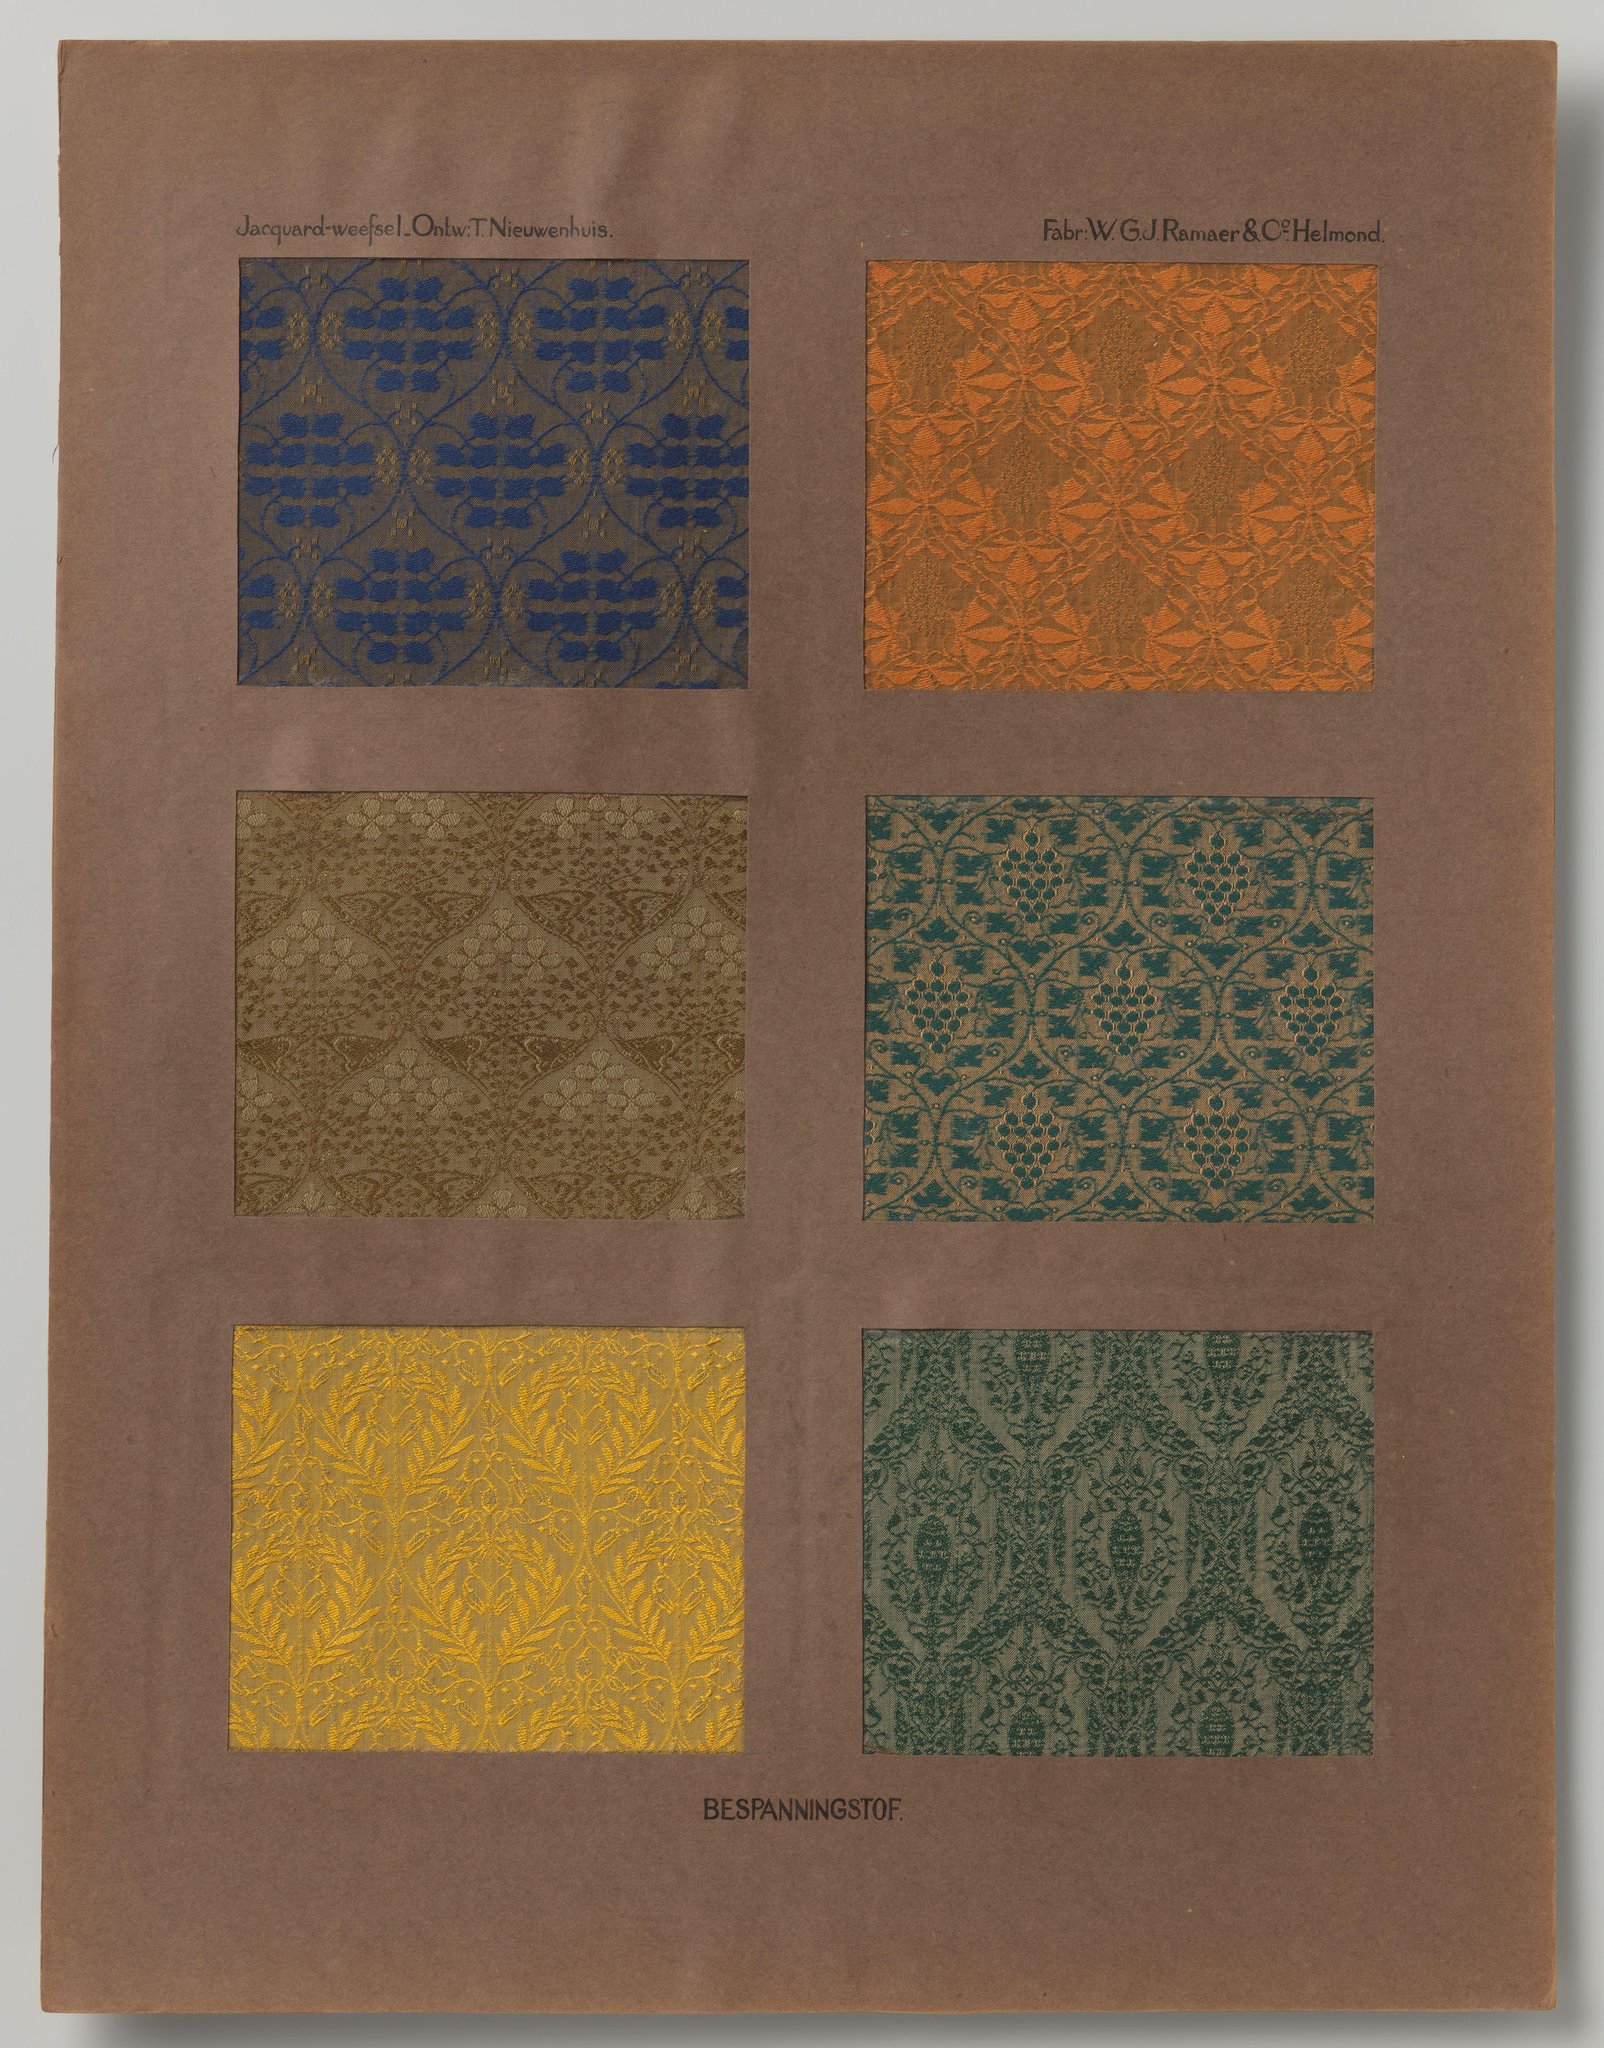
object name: sample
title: Stalen bespanningsstof naar ontwerp van Theo Nieuwenhuis in passe-partout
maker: theo nieuwenhuis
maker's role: designer, draughtsman, print maker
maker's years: 1866-1951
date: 1910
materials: cardboard, cotton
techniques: jacquard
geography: netherlands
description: Staalkaart met zes stalen bespanningsstof met verschillende florale patronen naar ontwerp van Theo Nieuwenhuis. In origineel passe-partout.